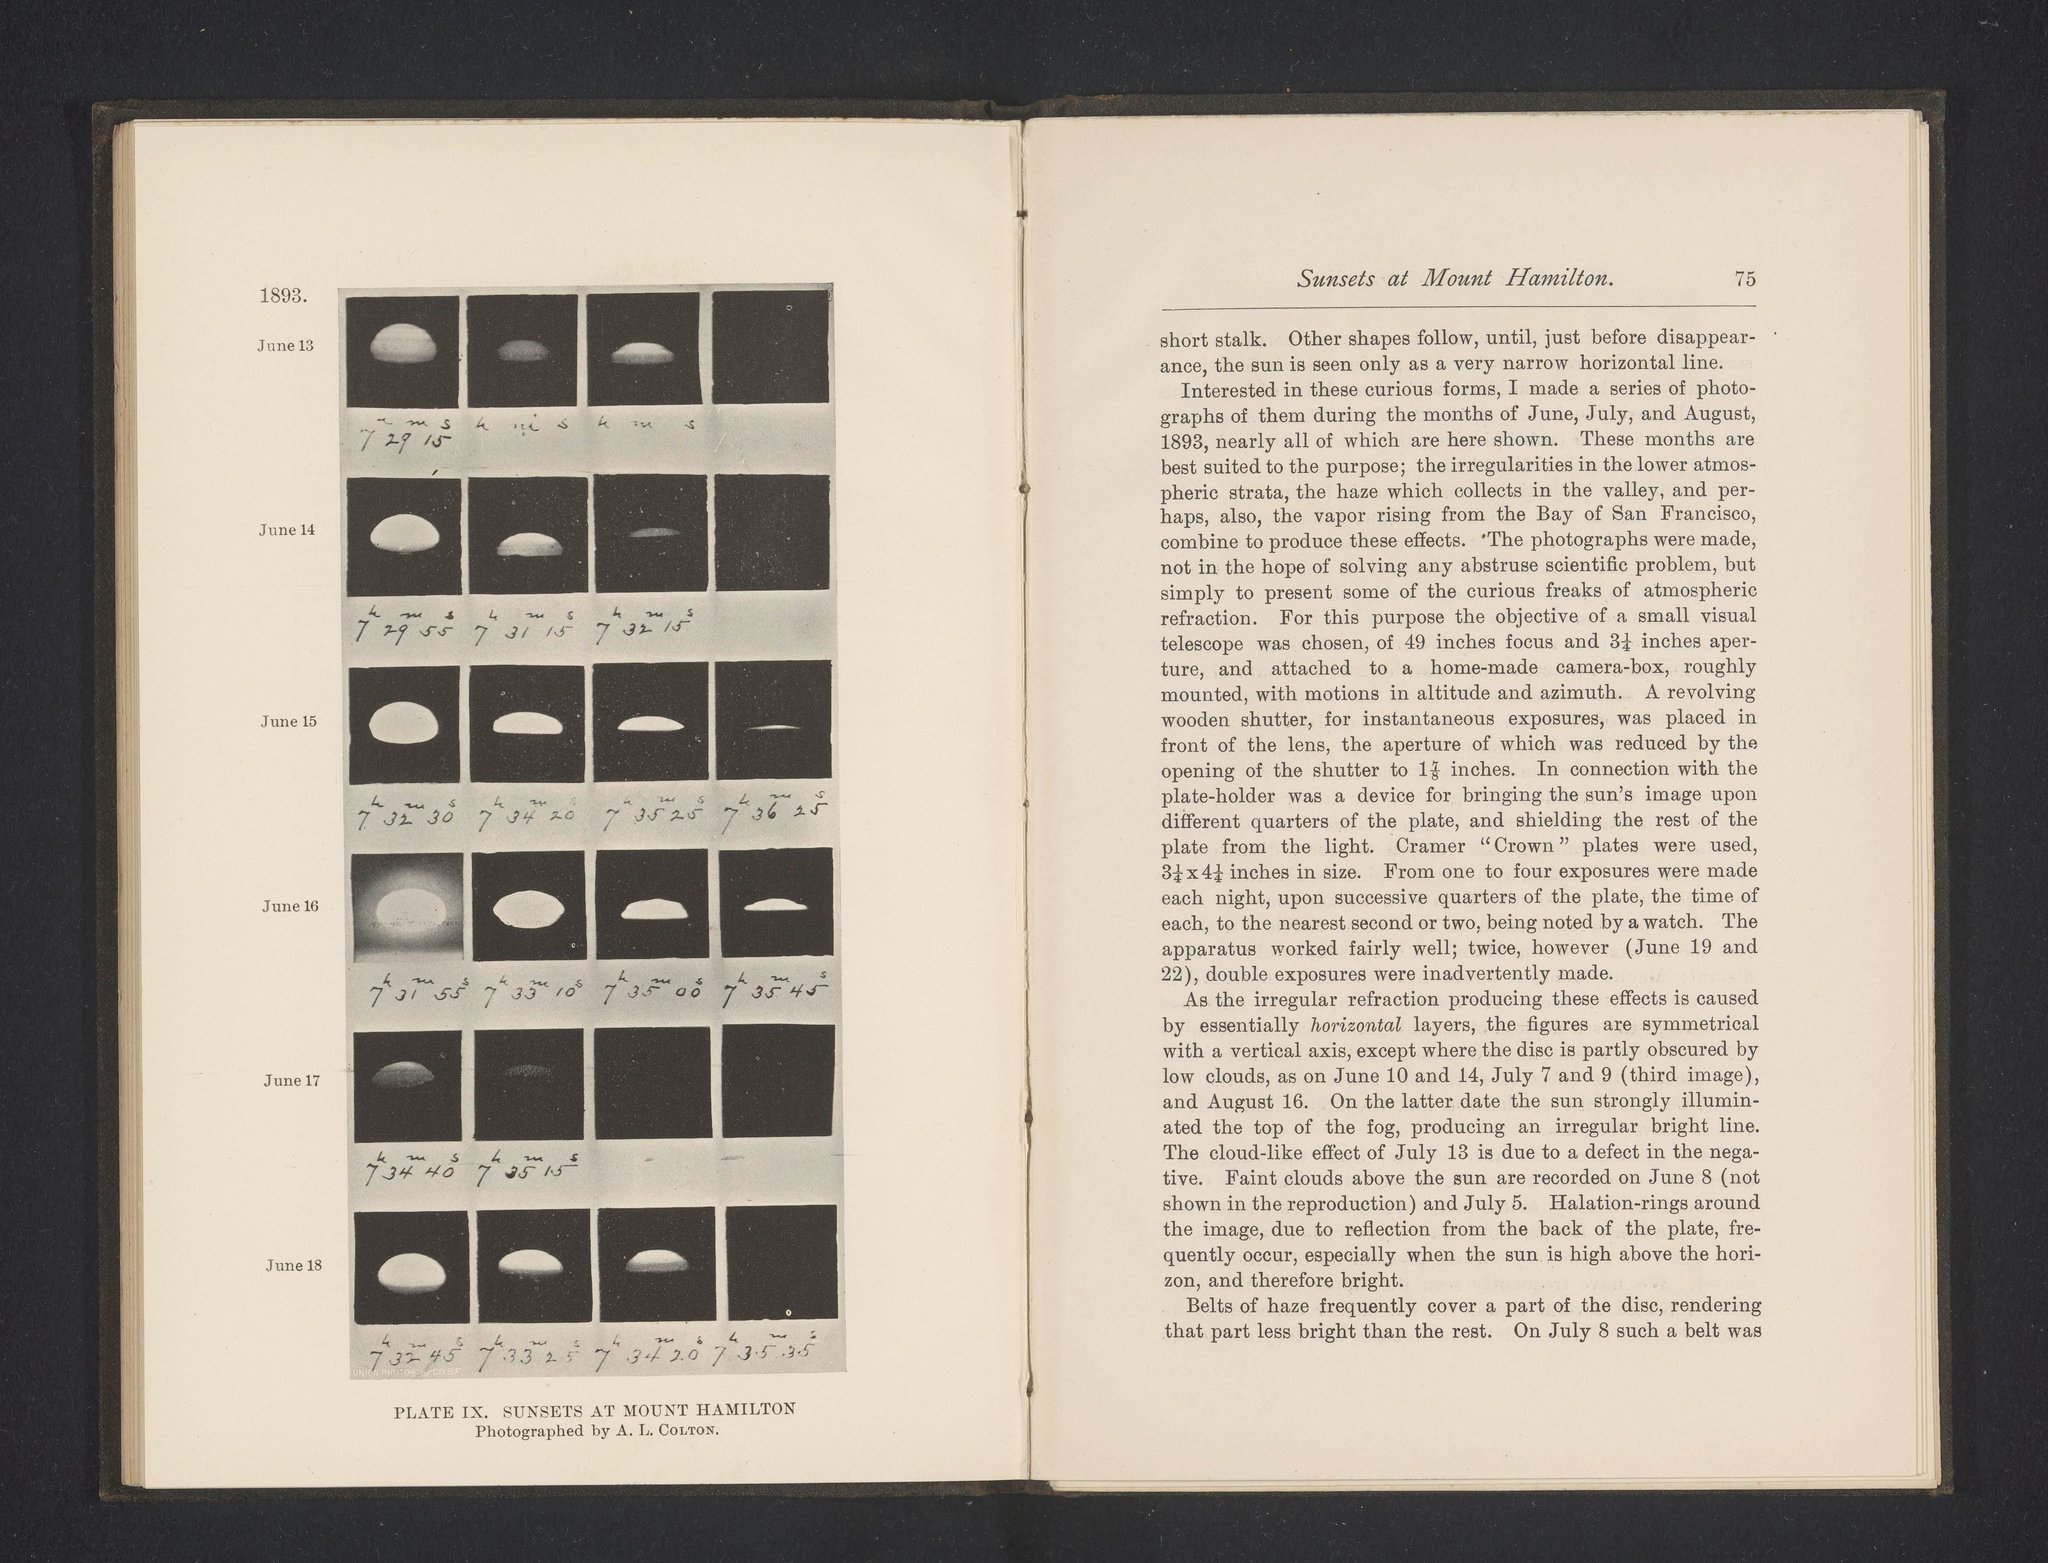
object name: photomechanical print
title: Overzicht van het verloop van de zonsondergang gezien vanaf Mount Hamilton te Californië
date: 1893-1895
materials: paper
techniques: autotype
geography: lick observatory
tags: sunset, astronomy (and cosmography)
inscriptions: date: ‘1893/ June 13/ June 14/ June 15/ June 16/ June 17/ June 18’